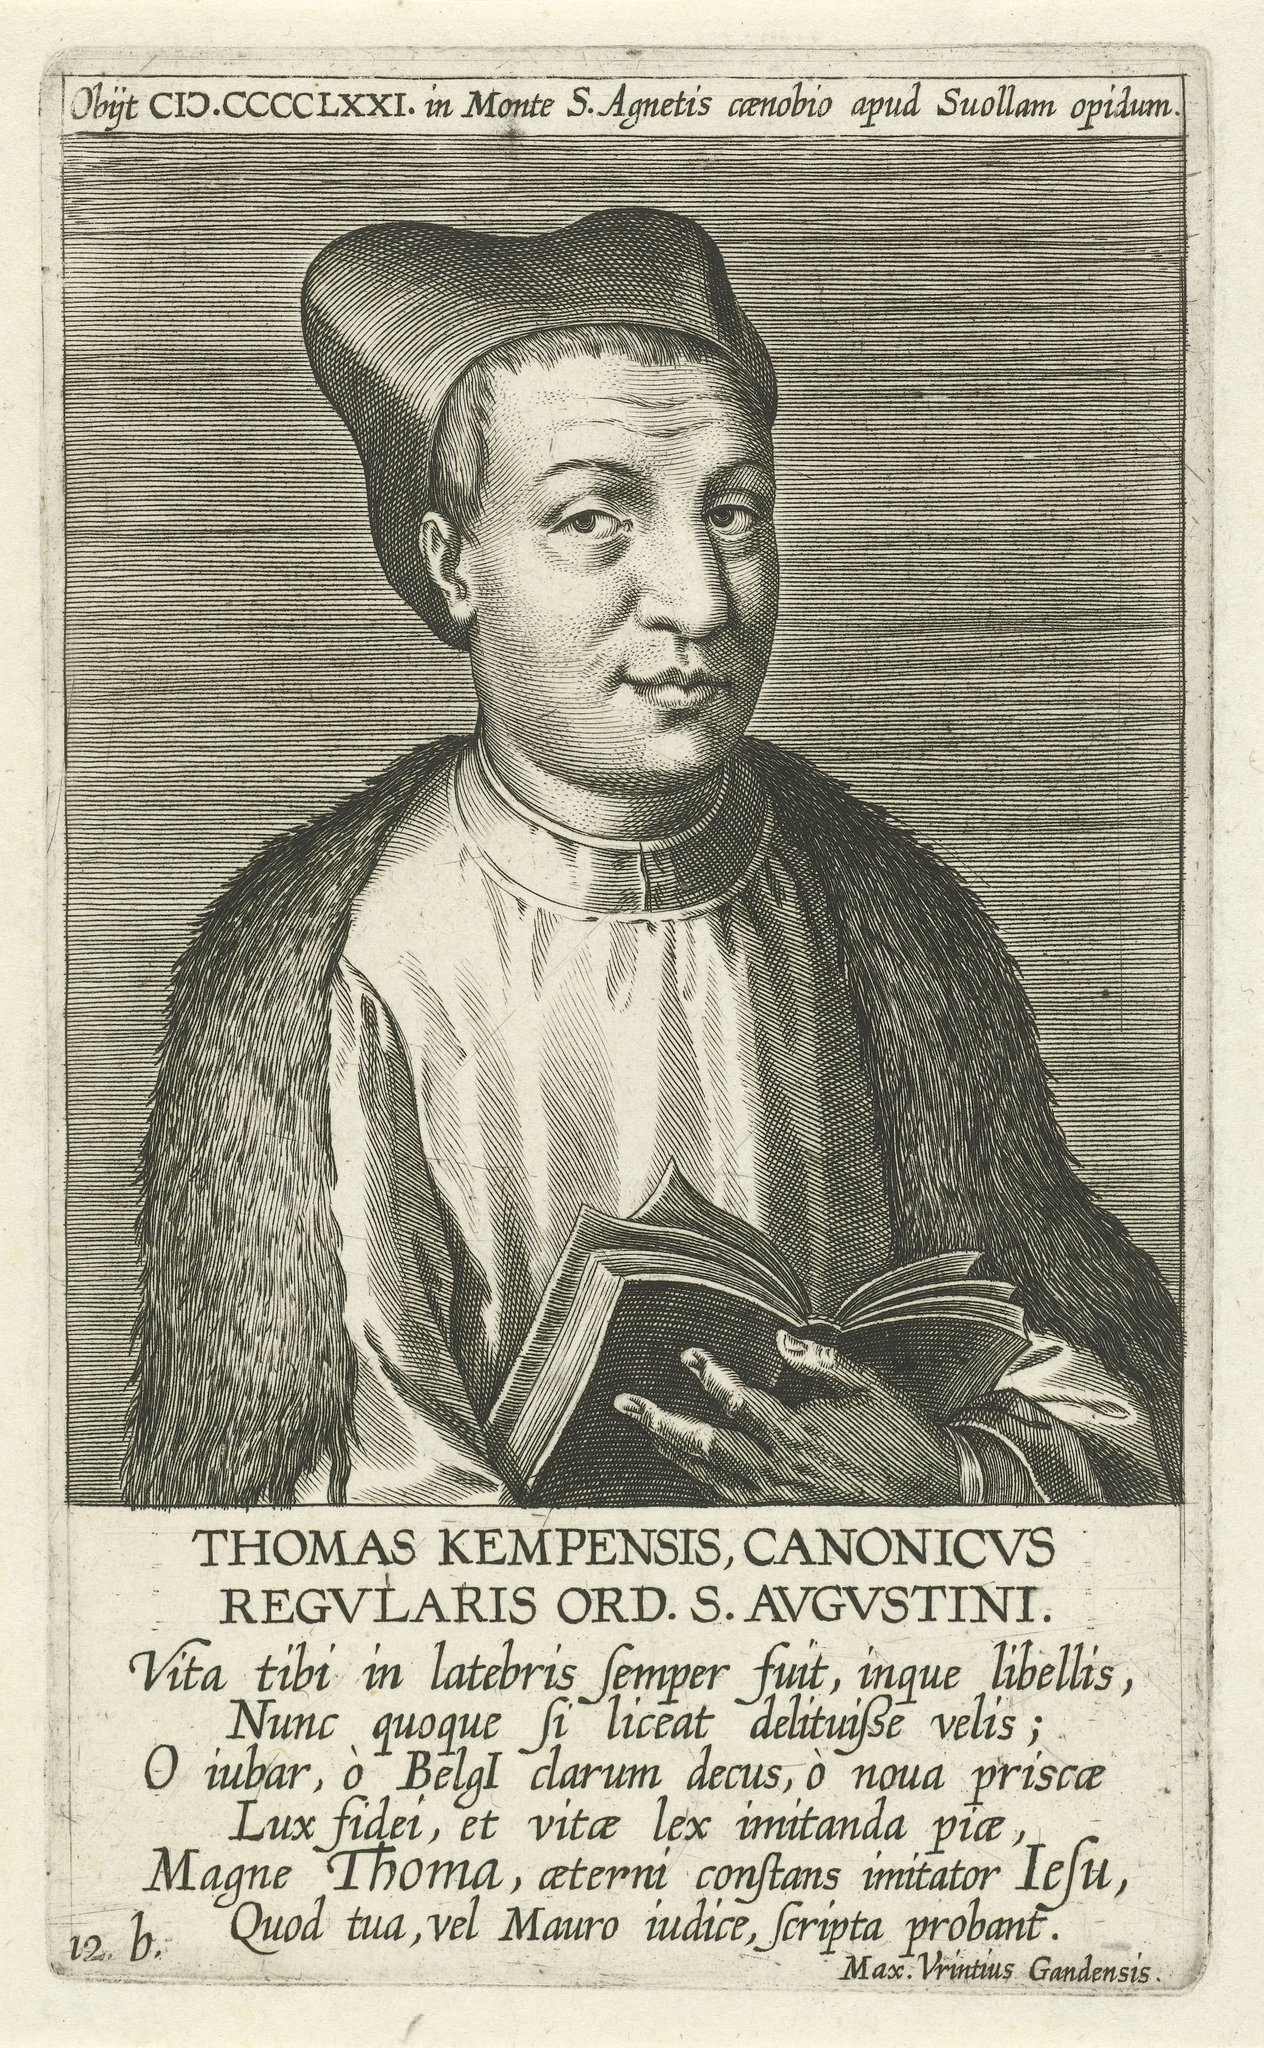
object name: print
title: Thomas Kempensis Canonicvs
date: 1608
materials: paper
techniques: engraving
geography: antwerp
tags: priest, thomas à kempis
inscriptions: collector's mark: Lugt 2228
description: Portret van Thomas à Kempis. Buste naar rechts. De prent heeft een Latijns boven- en onderschrift en maakt deel uit van een serie van beroemde Nederlandse en Vlaamse geleerden.